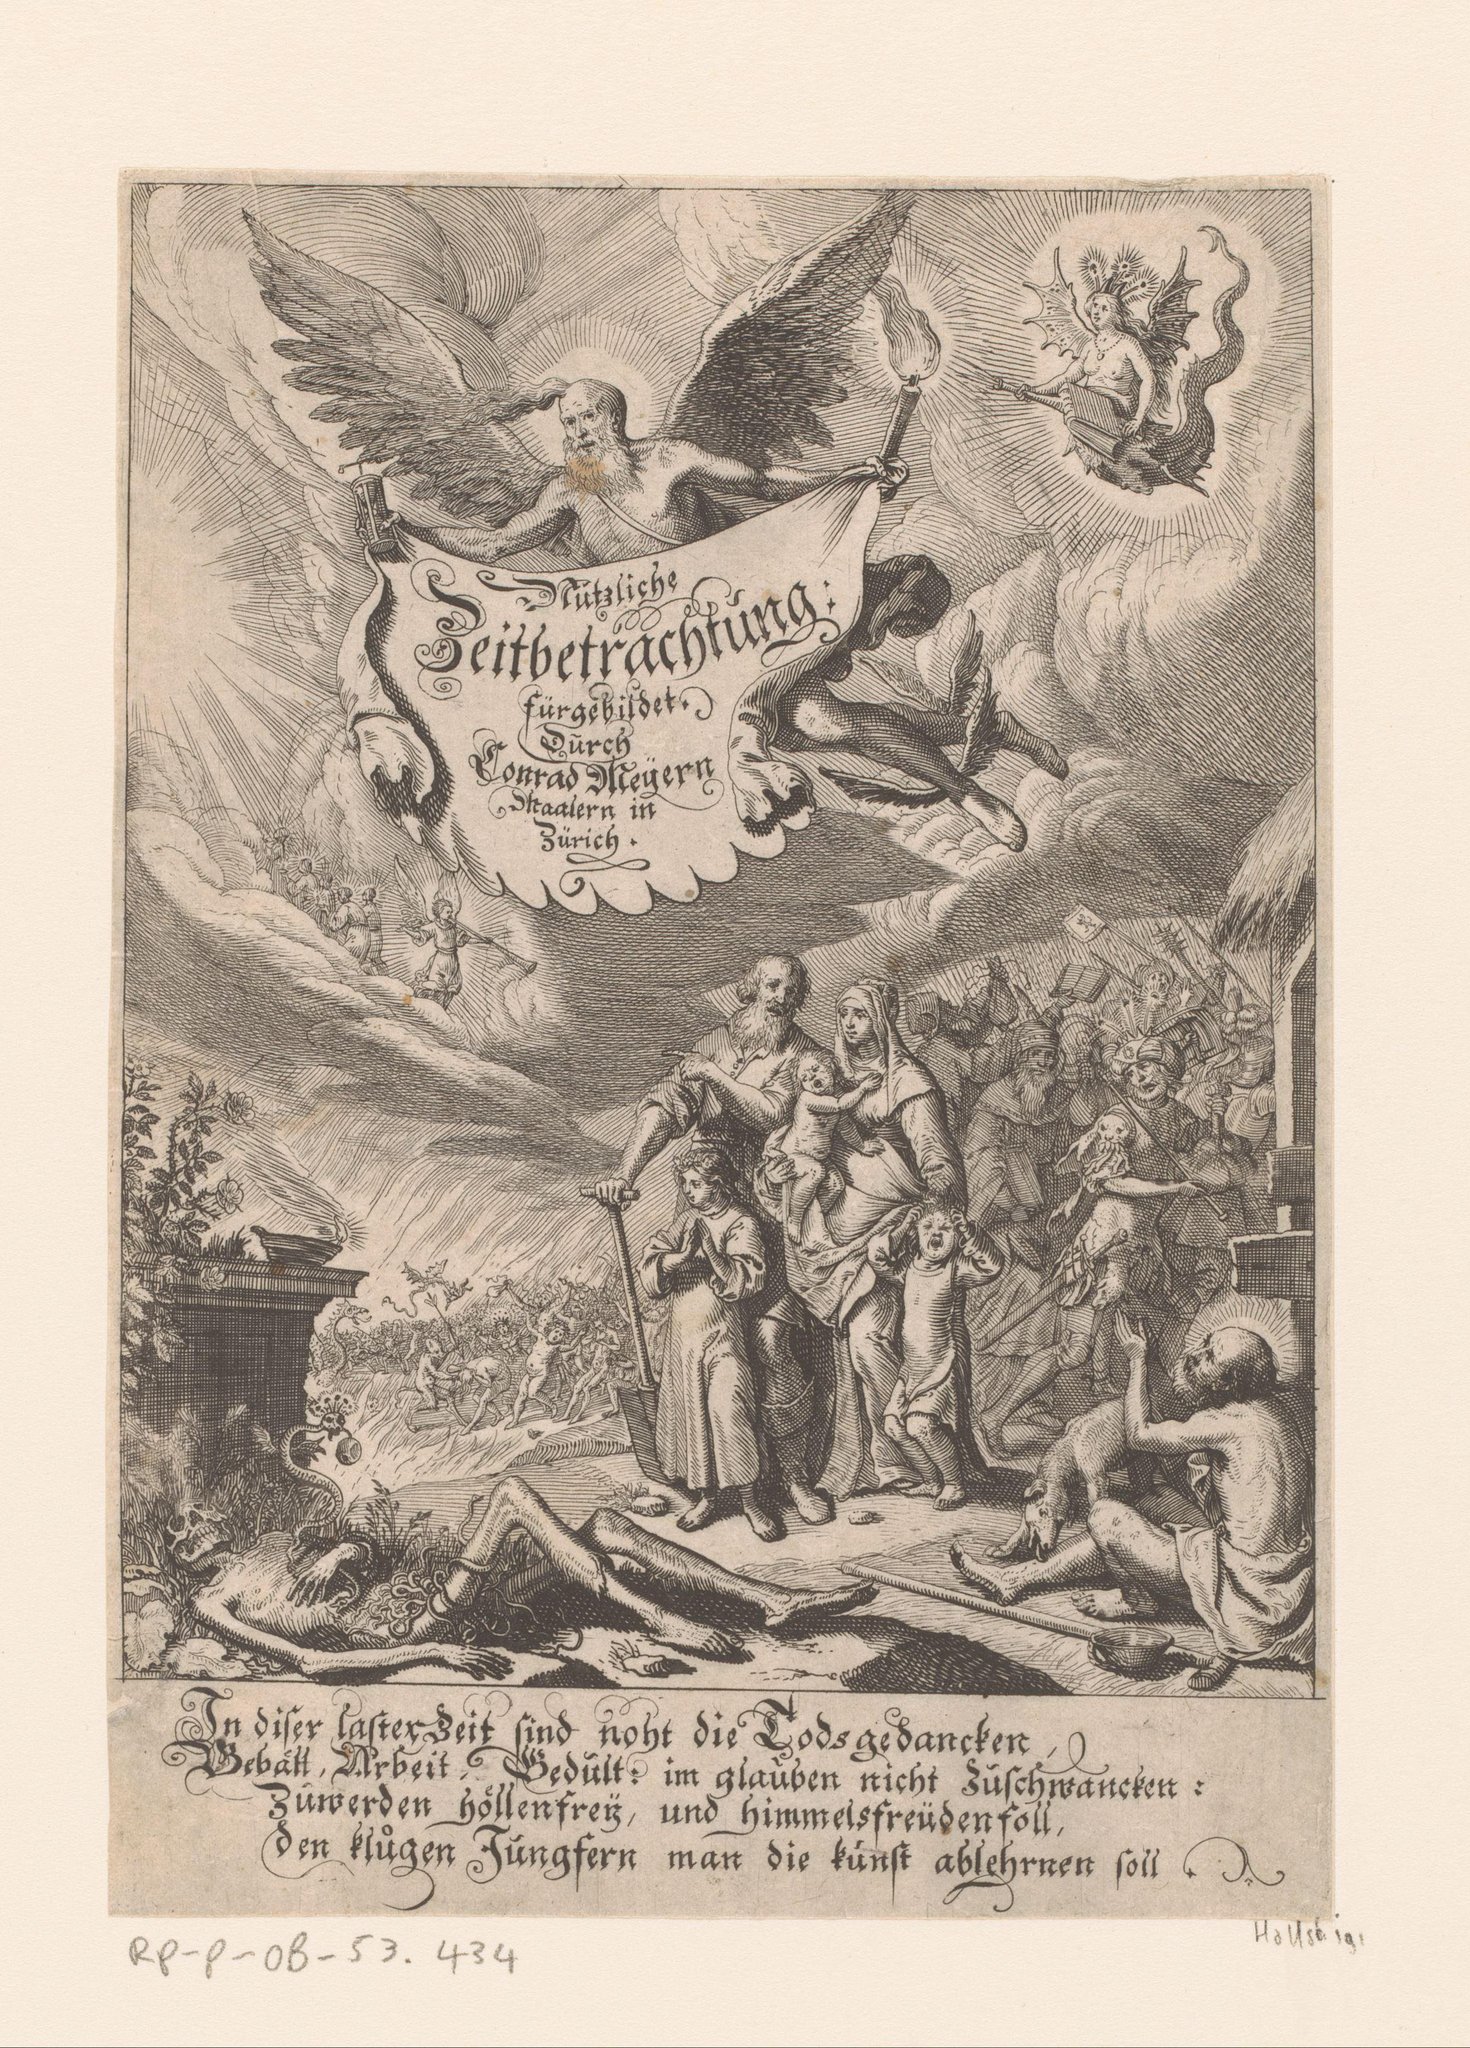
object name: print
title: De leeftijden van de mens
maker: conrad meyer (i)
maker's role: painter, print maker, publisher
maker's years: 1618-1689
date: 1675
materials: paper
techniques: etching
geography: zurich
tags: human life and its ages (young, adult, old, etc.), last judgement, father time, man with wings and scythe